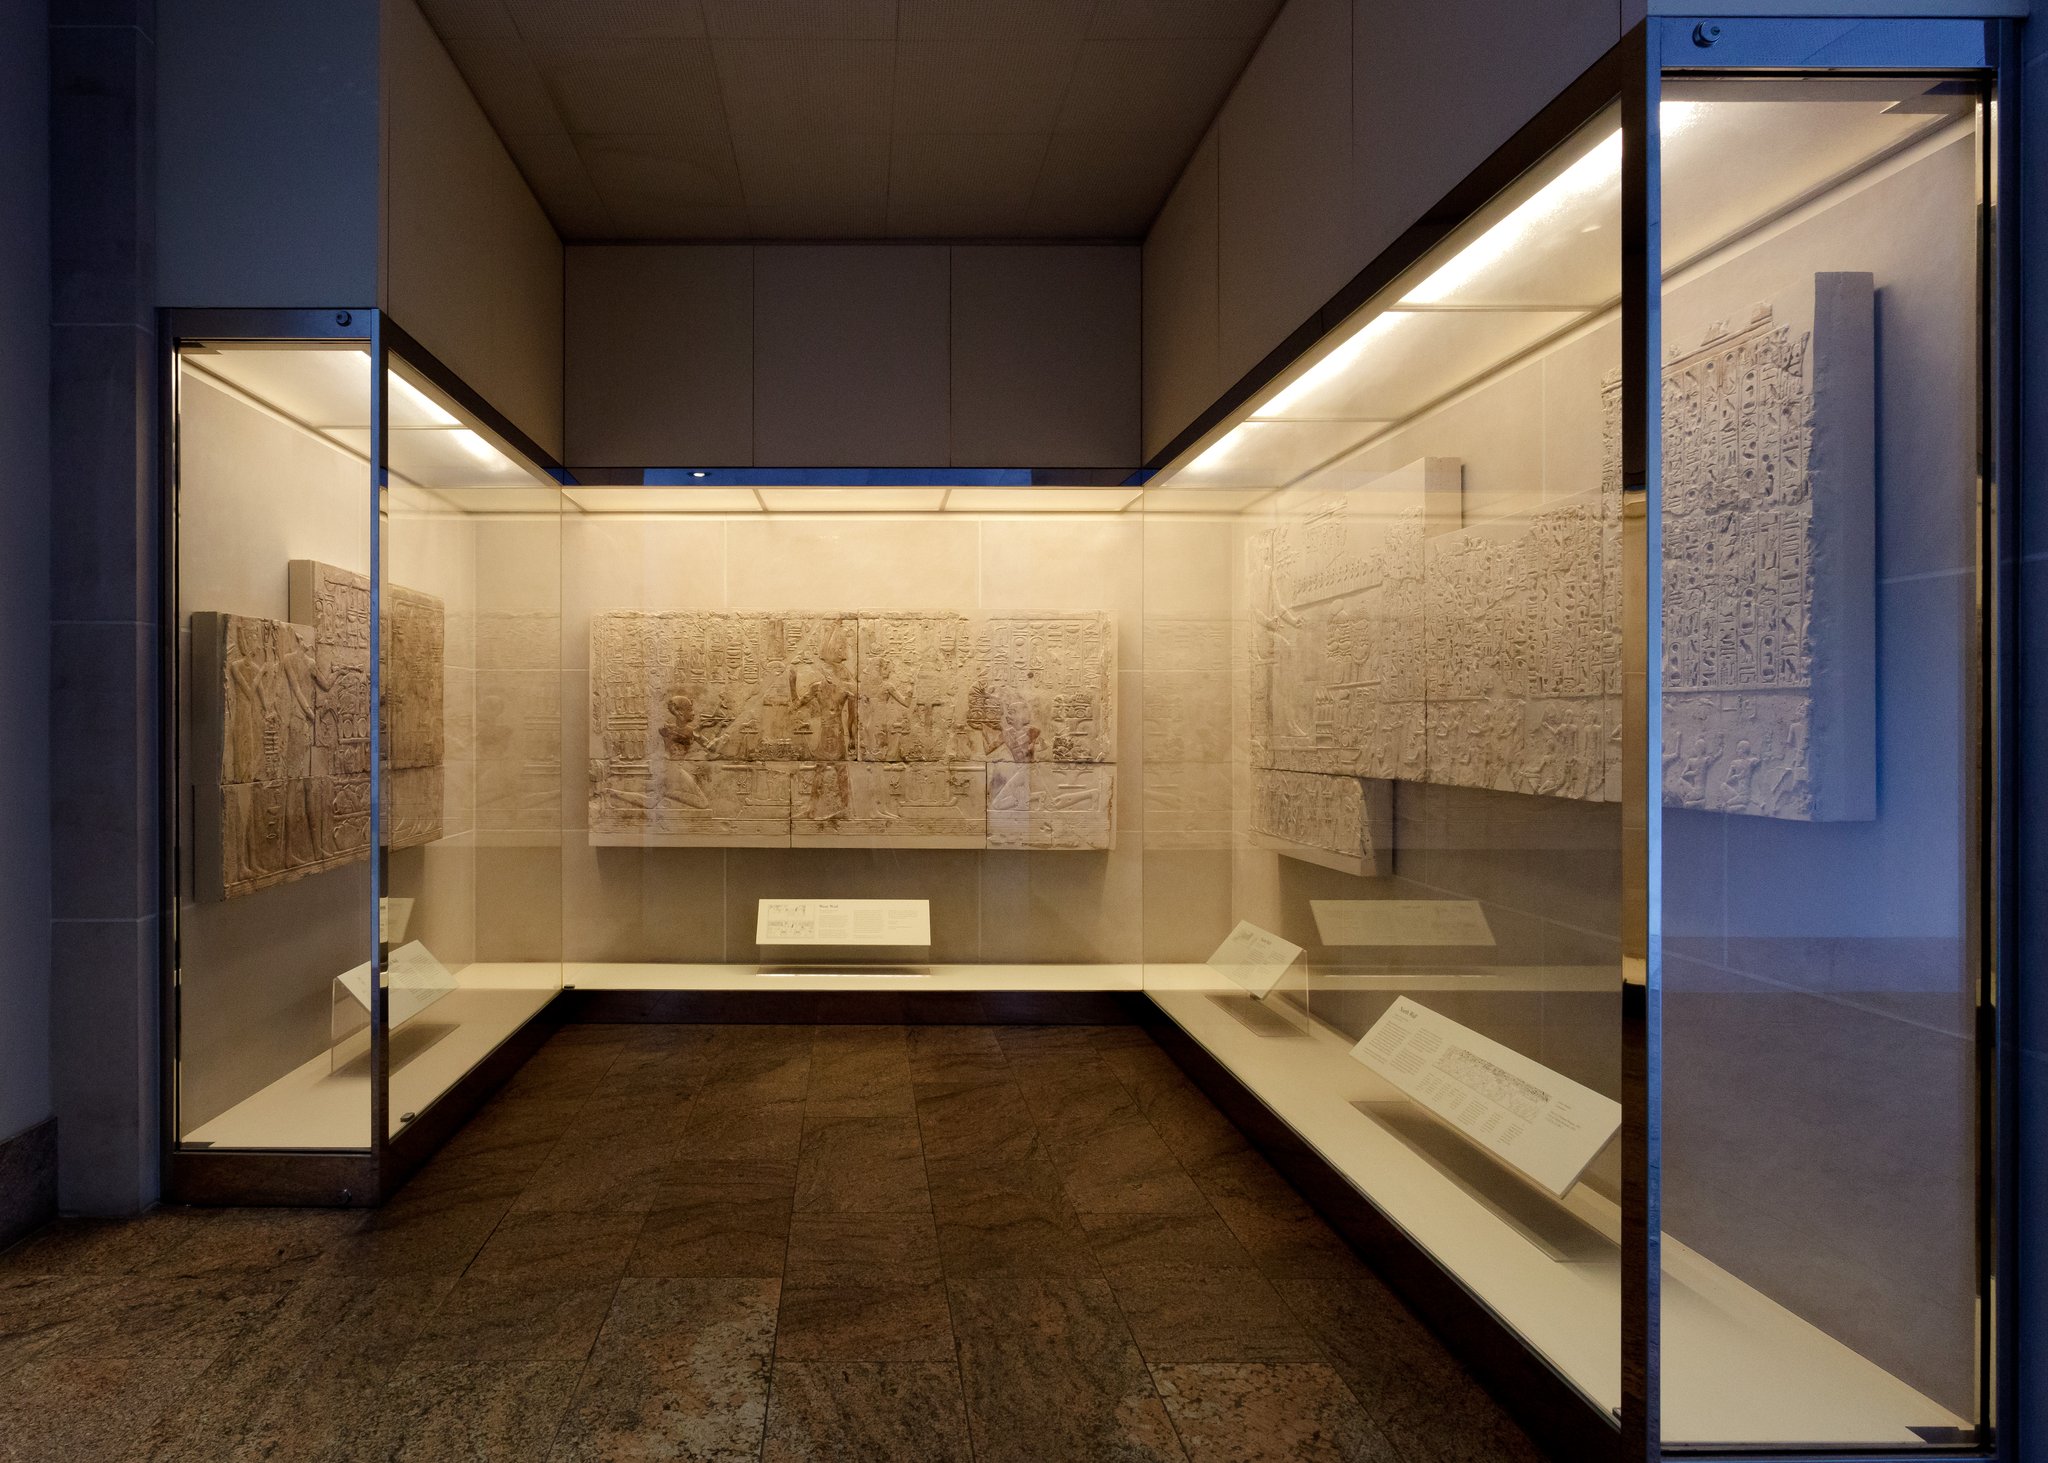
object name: relief, ramesses i chapel, south wall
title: Reliefs from a Chapel of Ramesses I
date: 1295-1294 BCE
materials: limestone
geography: egypt